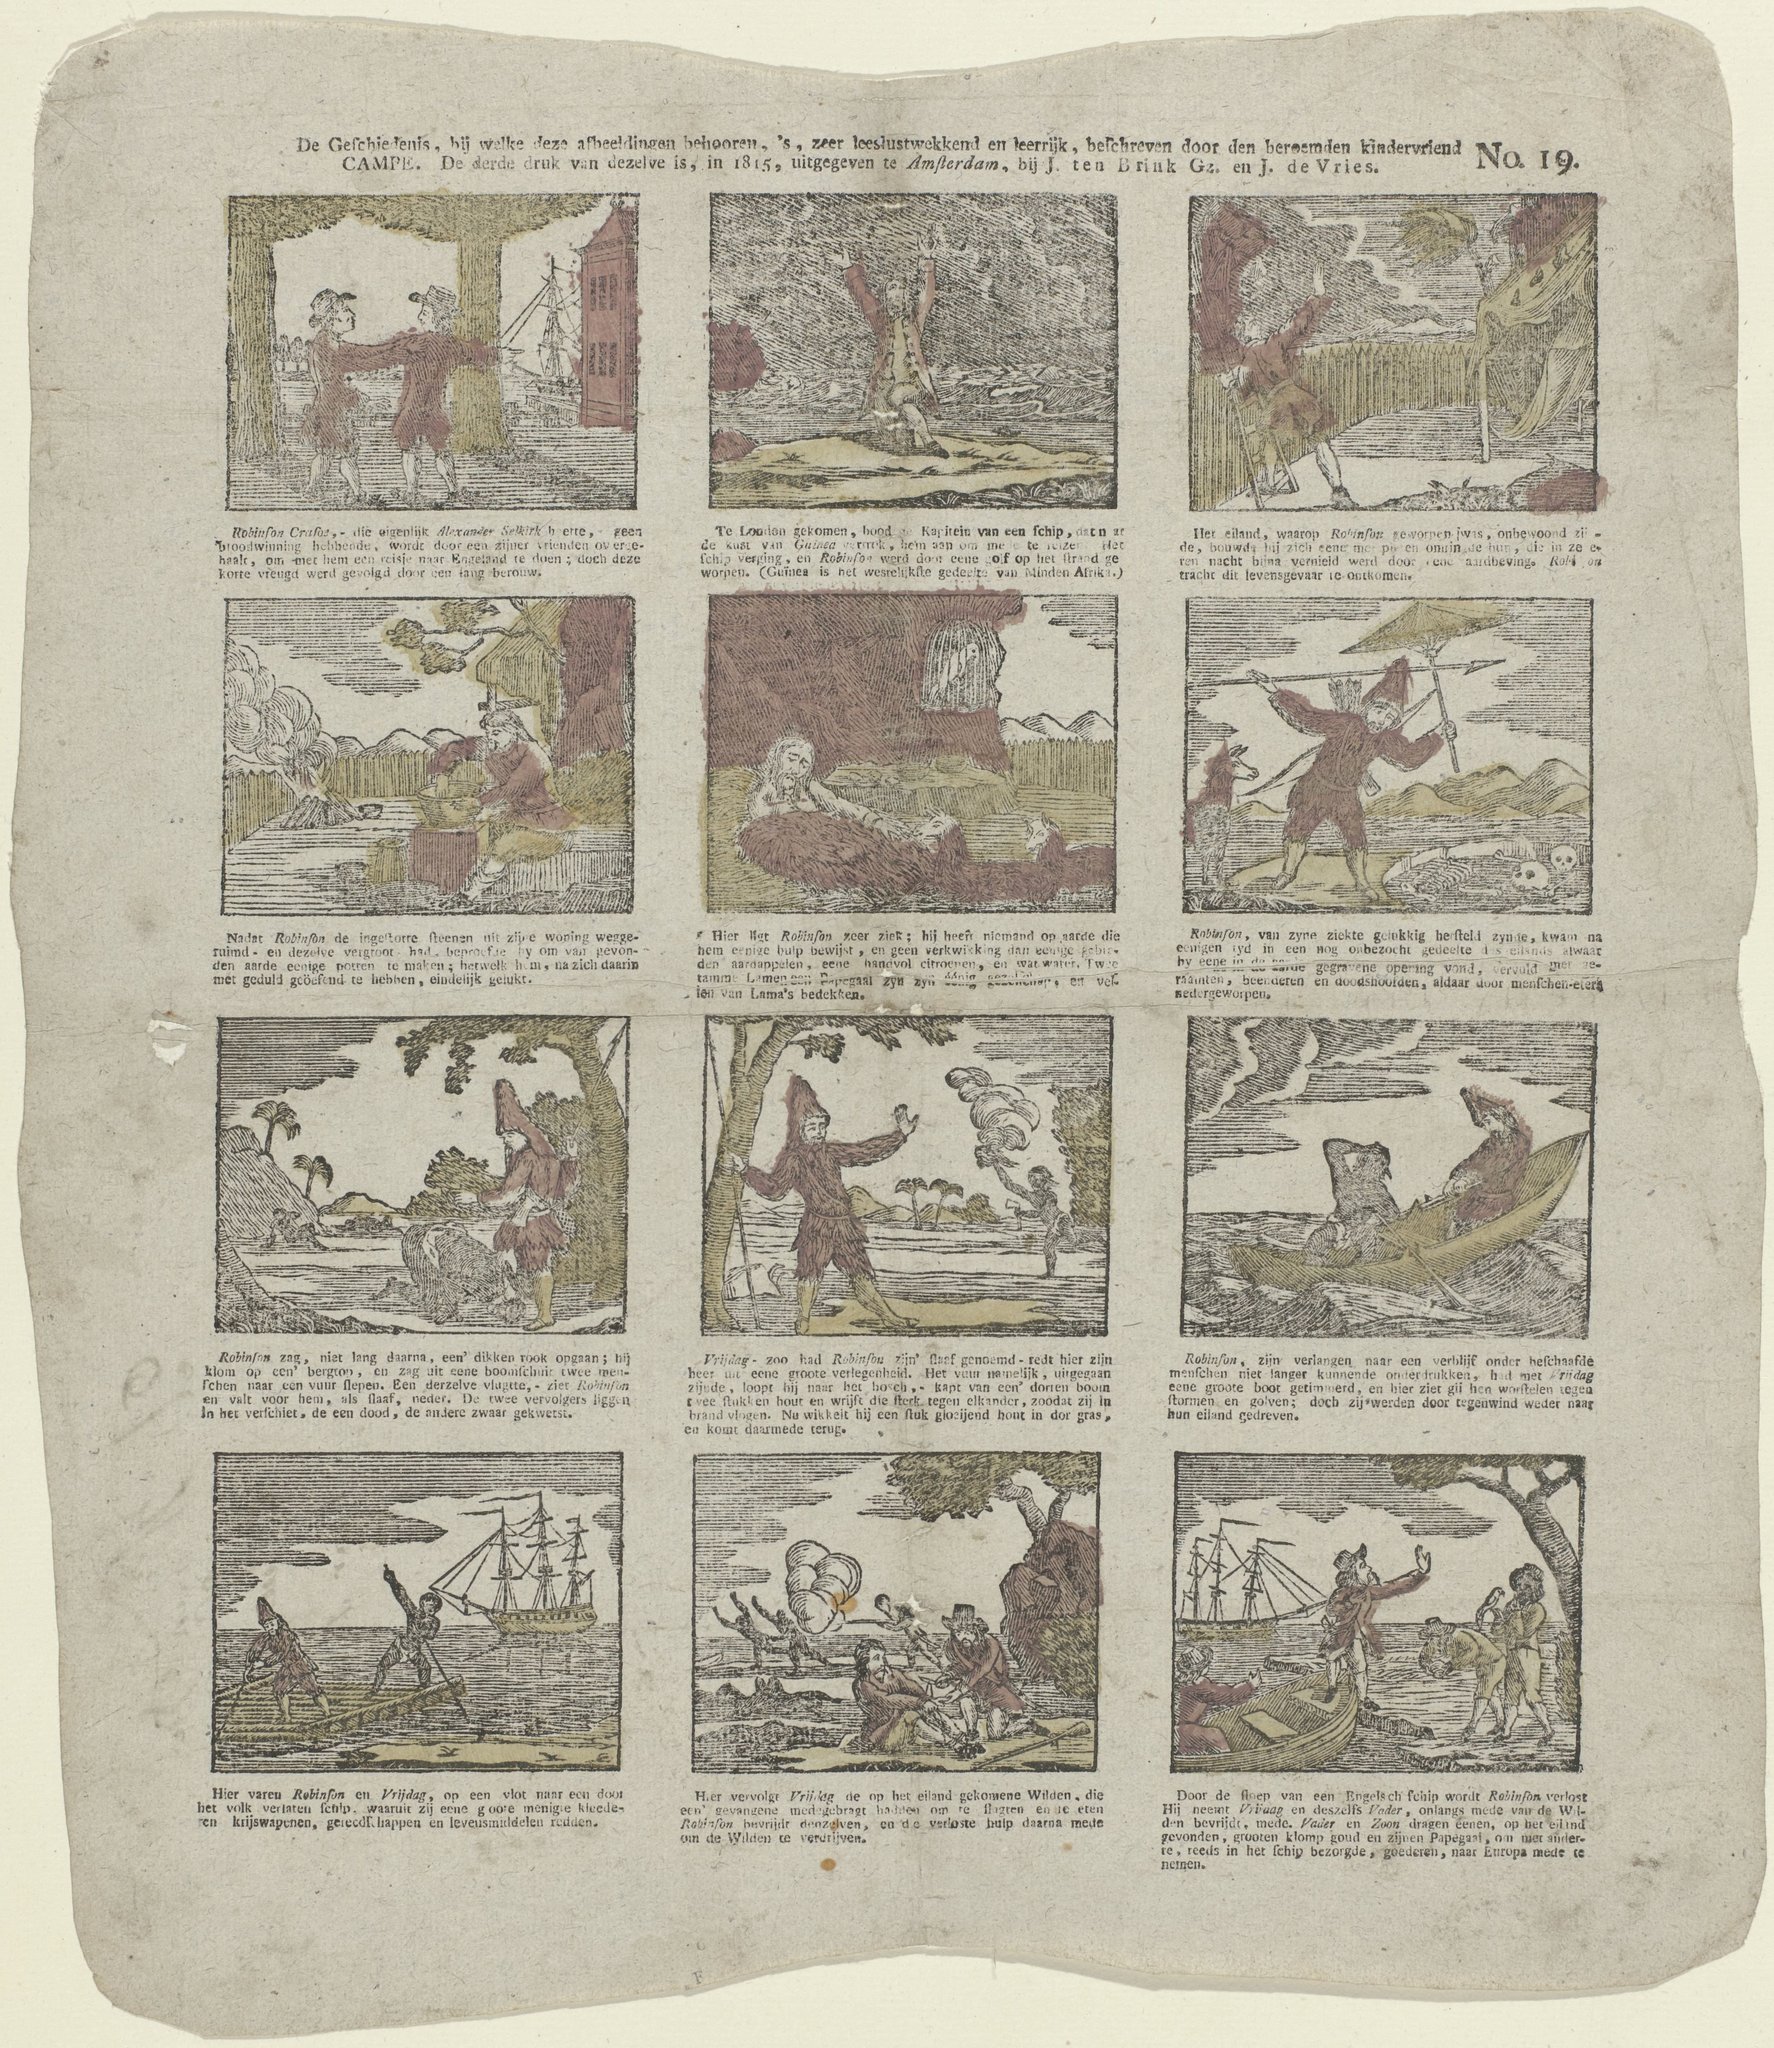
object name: popular print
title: De geschiedenis, bij welke deze afbeeldingen behooren, is, zeer leeslustwekkend en leerrijk, beschreven door den beroemden kindervriend / Camp (...)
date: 1820-1838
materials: paper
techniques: colour, letterpress printing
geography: rotterdam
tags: (scenes from) specific works of literature: defoe, robinson crusoe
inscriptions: collector's mark: Lugt 2228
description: Blad met 12 voorstellingen uit het verhaal van Robinson Crusoe die strandt op een eiland. Onder elke afbeelding een onderschrift. Genummerd rechtsboven: No. 19.